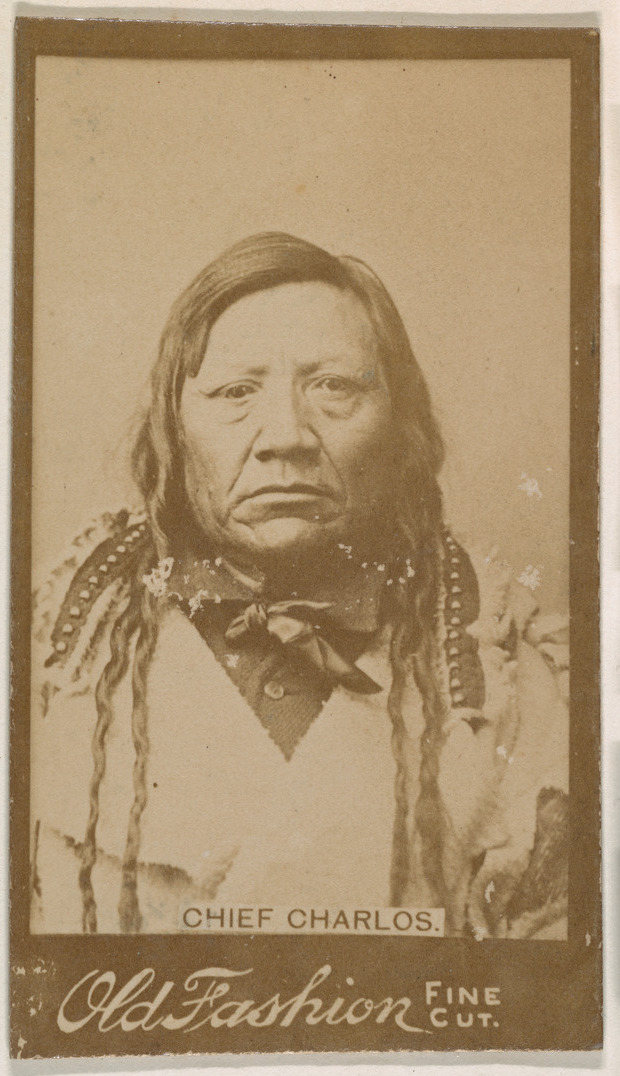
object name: photograph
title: Chief Charlos, from the Indian Chiefs series (N681) promoting Old Fashion Fine Cut Tobacco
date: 1888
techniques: albumen silver print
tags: men,portraits